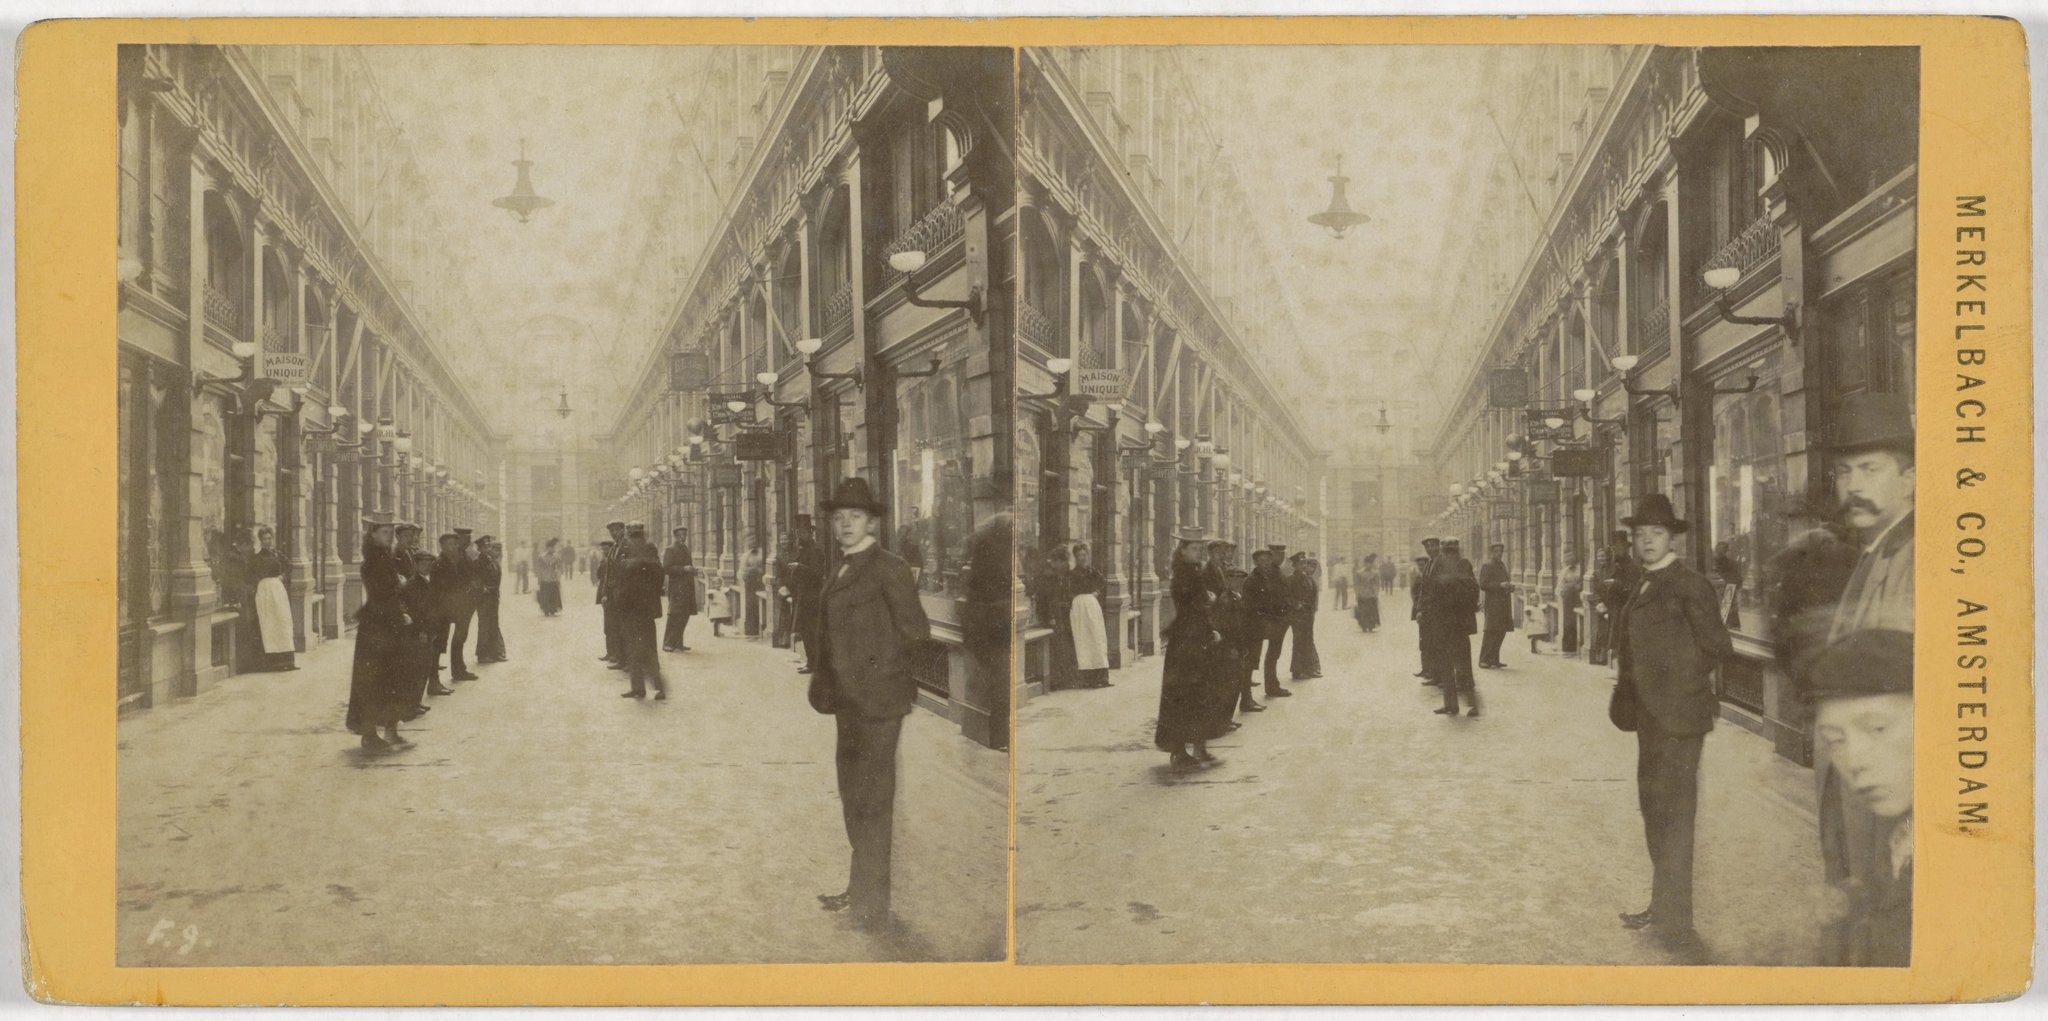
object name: stereograph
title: Aardrijkskundige beeldengalerij, verzameld door M.J. Broekhuijsen, hoofd eener school te Amsterdam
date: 1900-1902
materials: cardboard, paper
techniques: albumen print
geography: the hague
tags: arcade ~ architecture, shop-window, show-window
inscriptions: inscription: ‘in Den Haag: overdekte winkelstraat. We zien hier slechts de helft, daar de/ straat aan het eind een bocht maakt. Boven ons in 't midden electrische verlichting.’, number: ‘F.9.’, number: ‘9.’